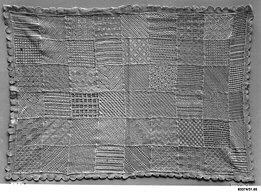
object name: sampler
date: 1701-1800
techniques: embroidery